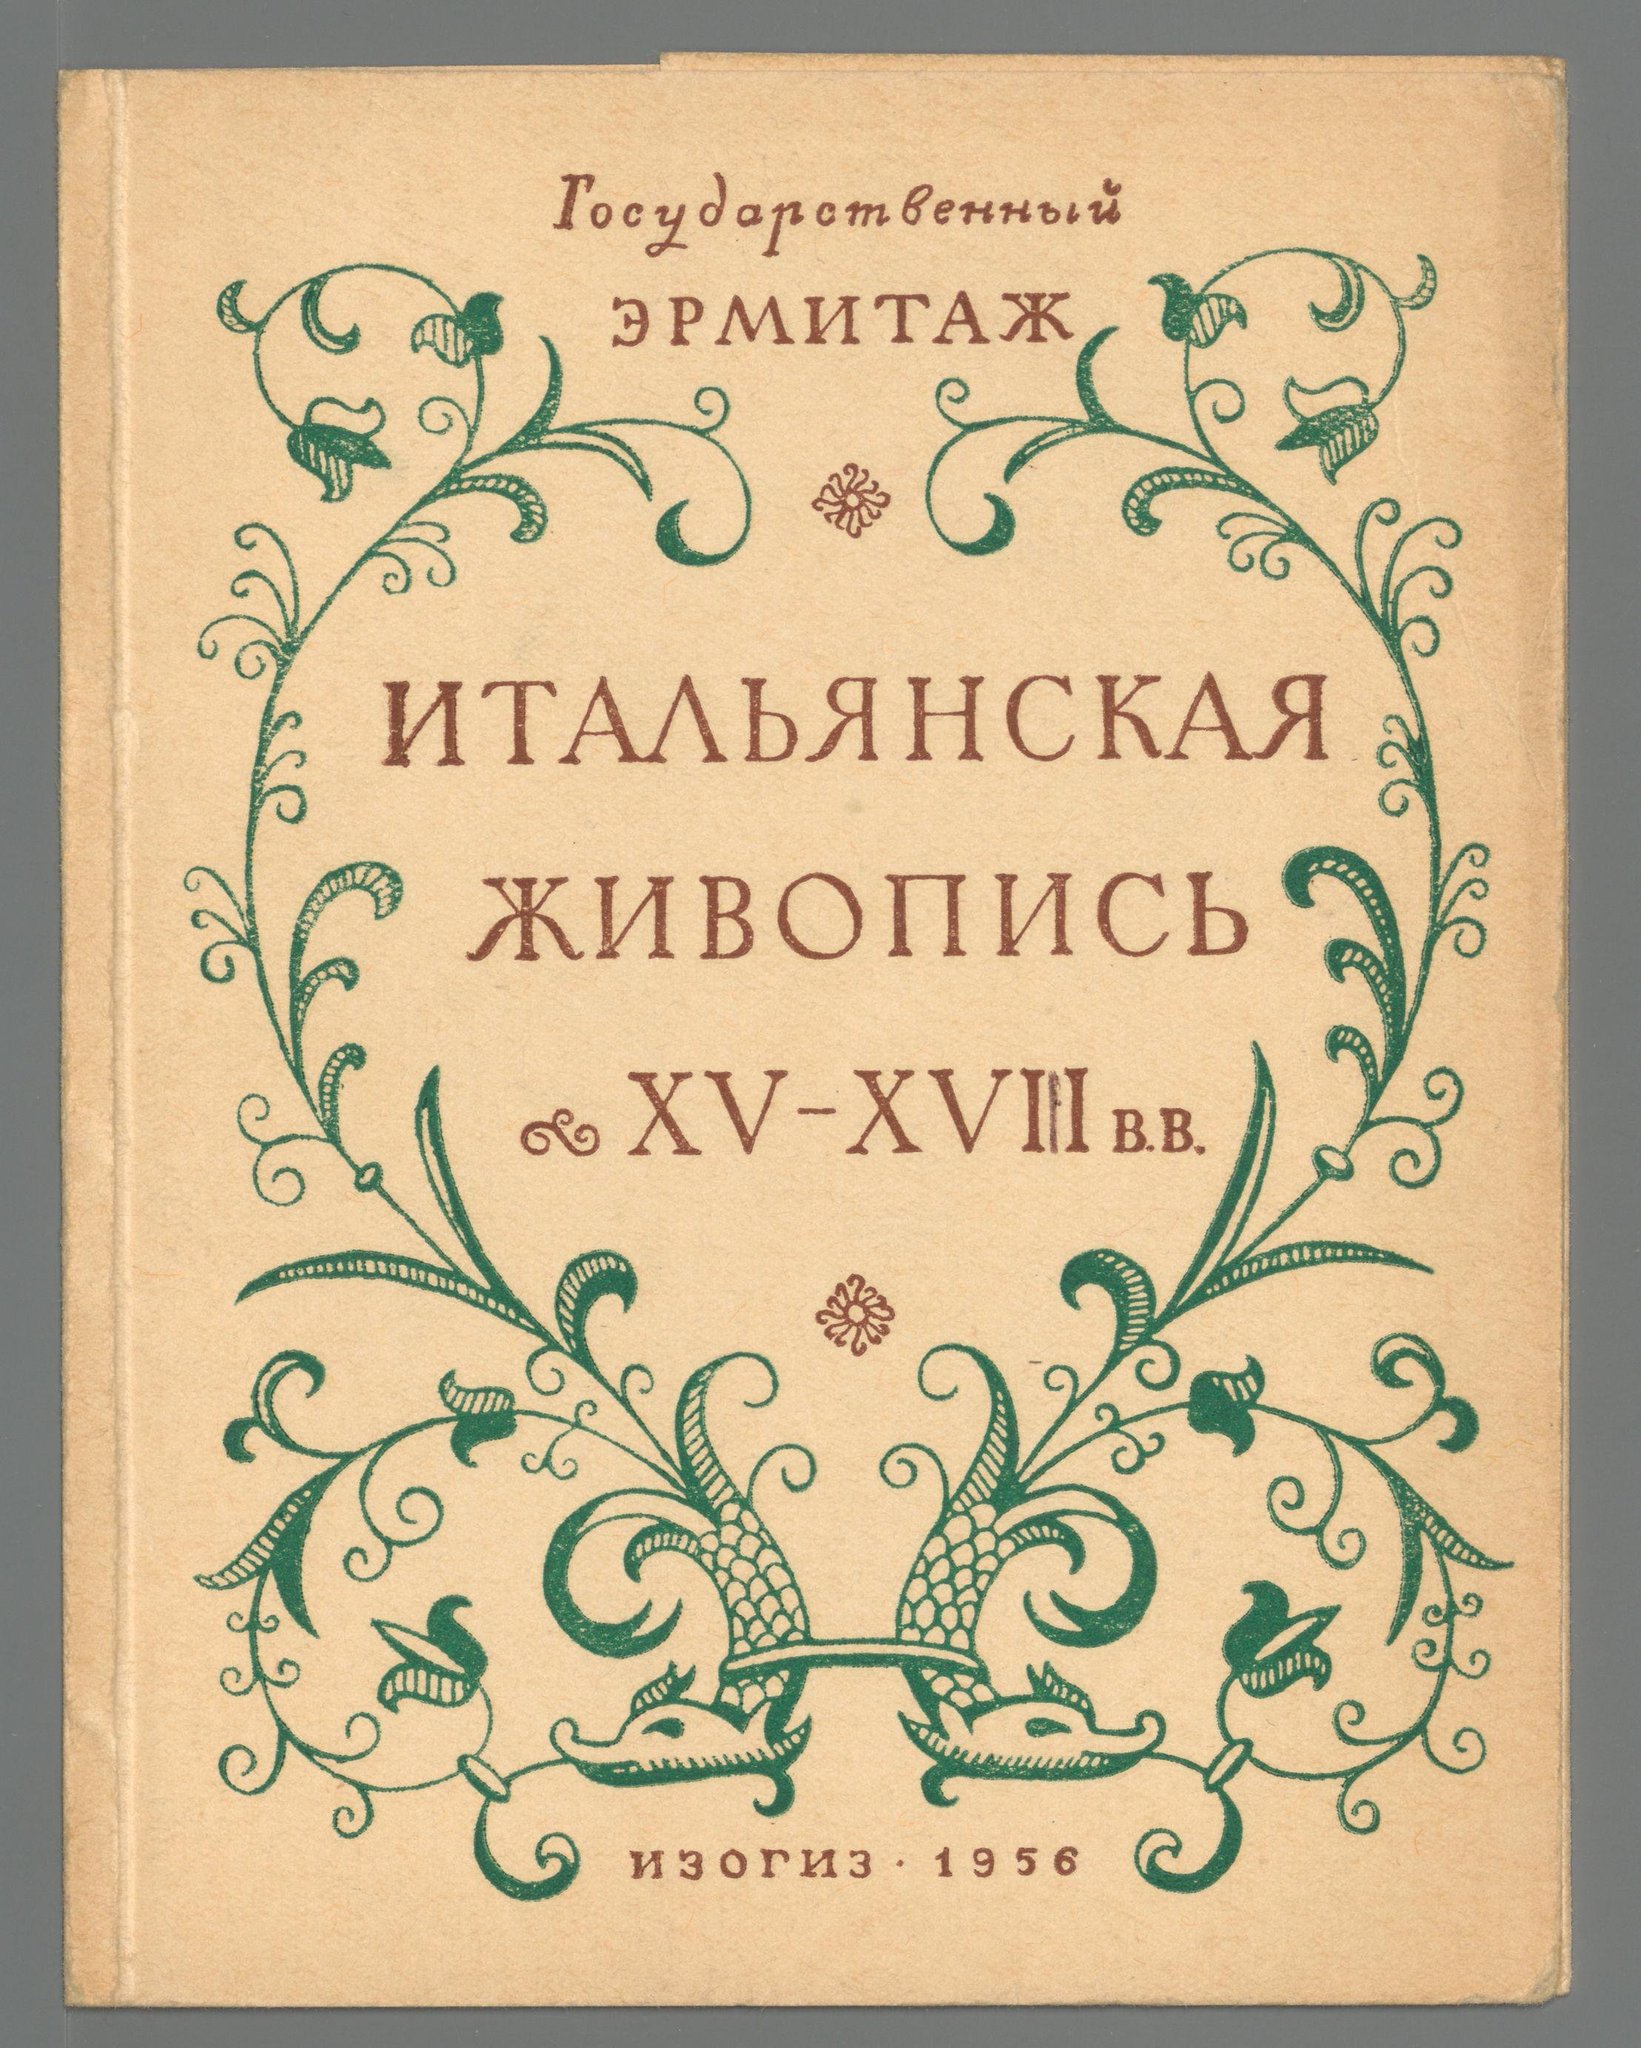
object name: wrapper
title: Omslag voor twaalf prentbriefkaarten met kunstreproducties van Italiaanse schilderijen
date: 1956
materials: paper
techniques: lithograph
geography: moscow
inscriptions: date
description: Het omslag is bedoeld voor twaalf prentbriefkaarten. In dit exemplaar zijn negen prentbriefkaarten aangetroffen.